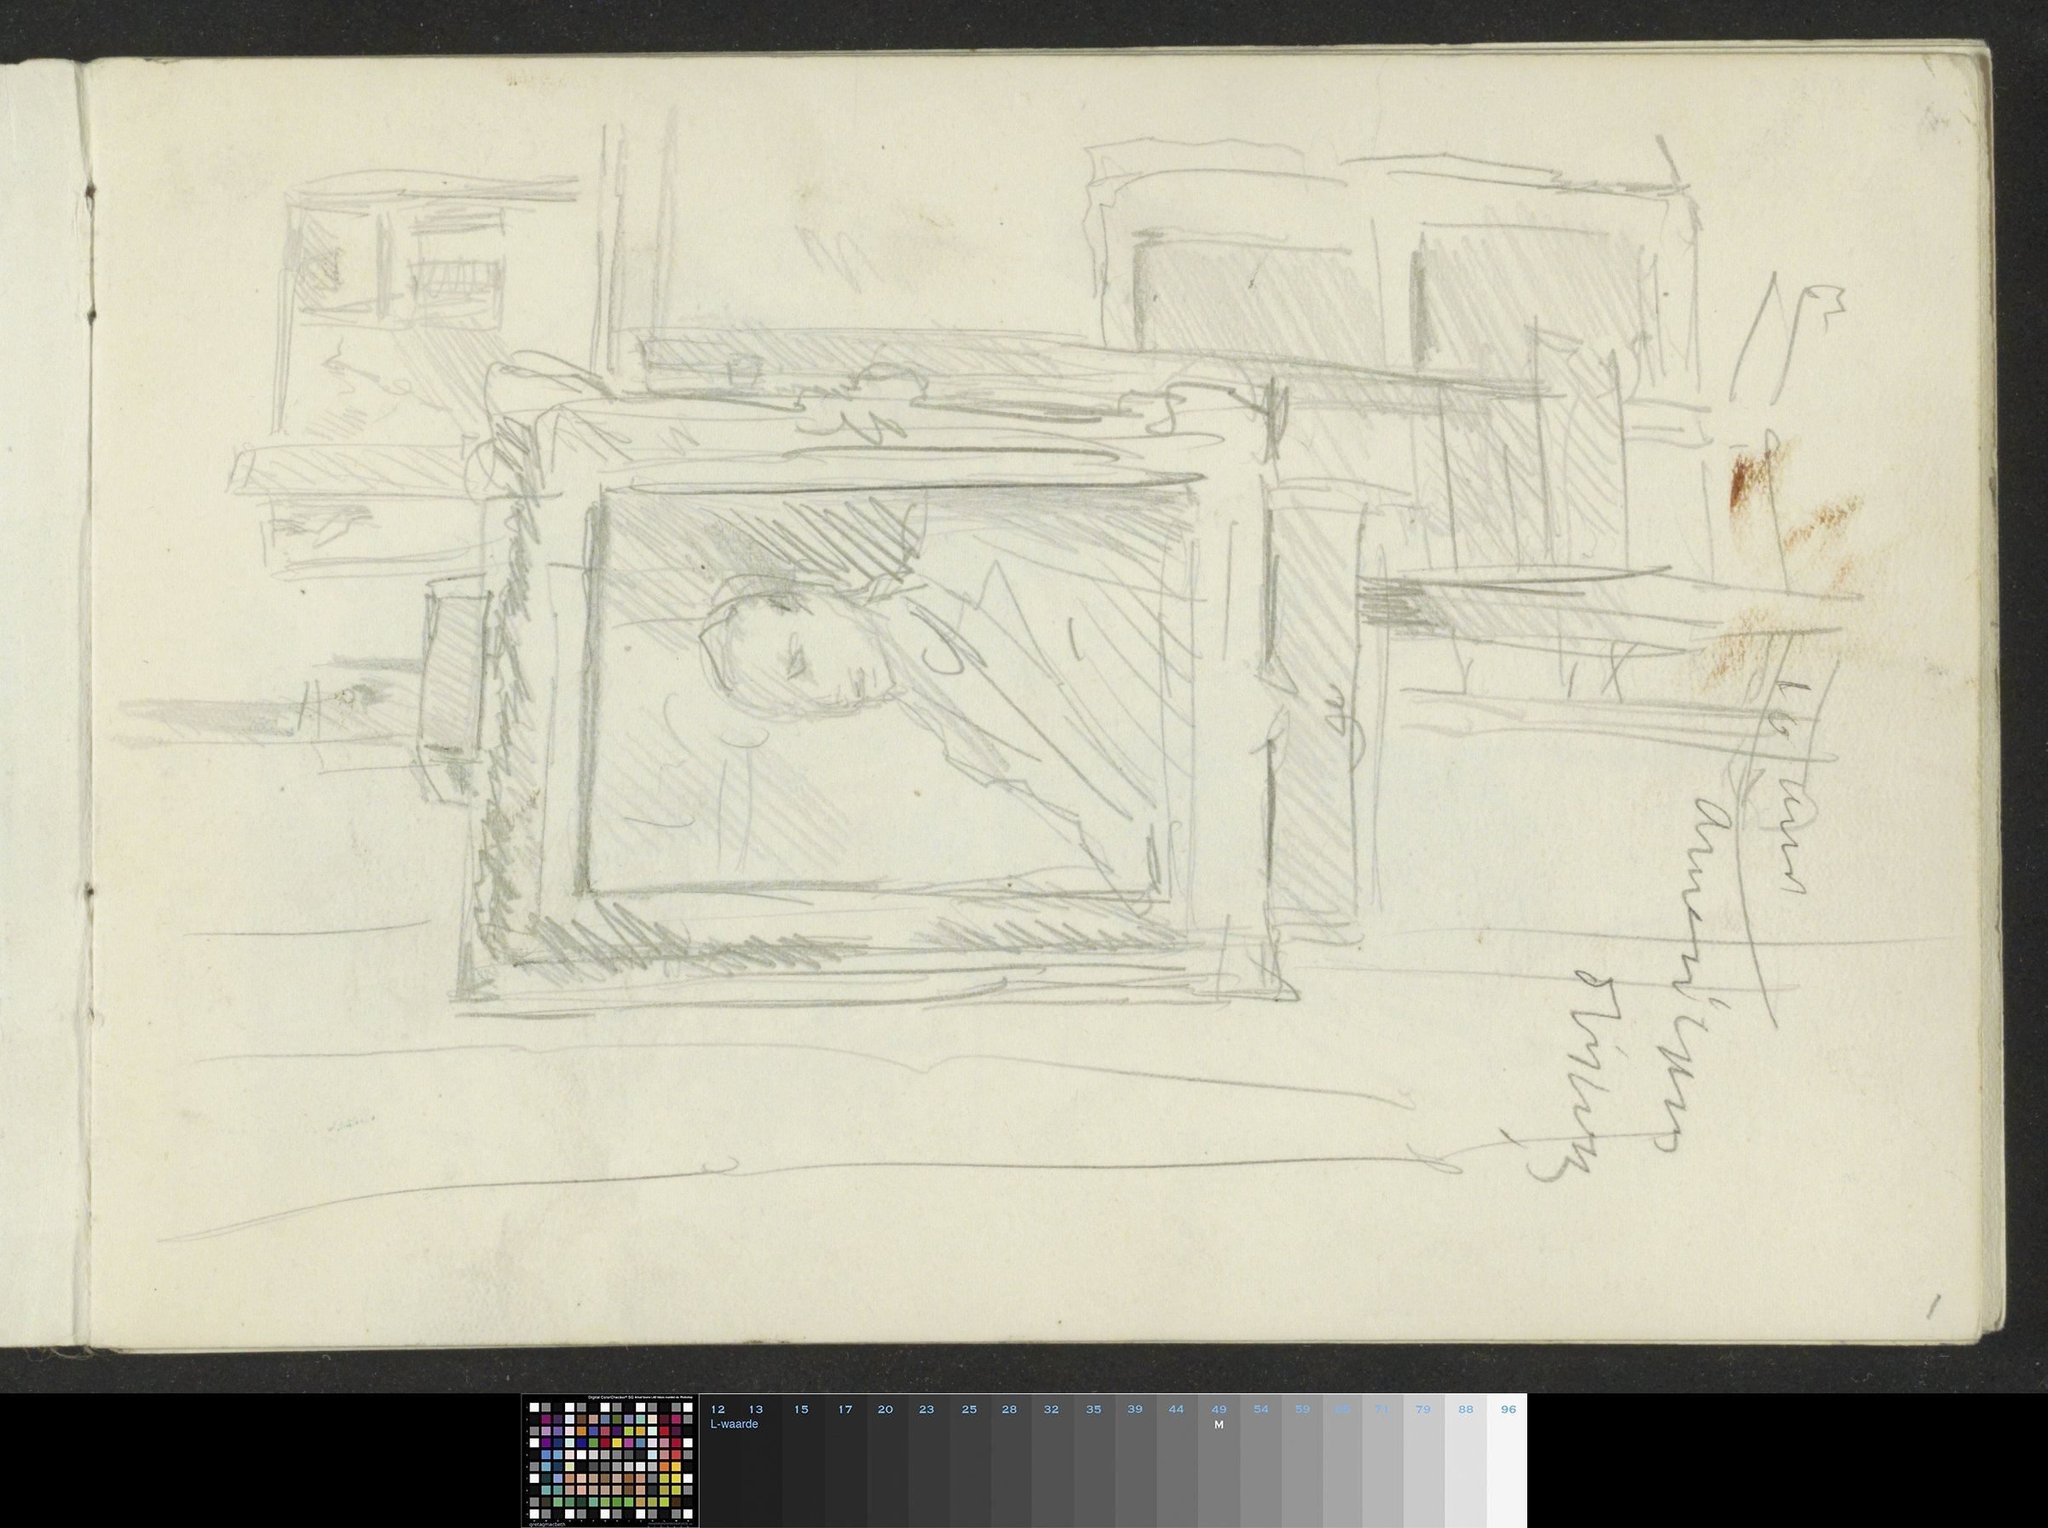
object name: sketchbook leaf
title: Schilderij op een ezel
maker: isaac israels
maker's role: draughtsman, painter, print maker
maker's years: 1865-1934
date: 1875-1934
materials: paper, pencil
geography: the hague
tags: easel, picture, painting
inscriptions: annotation: ‘10 uur / Arn[...] / slijpers[?]’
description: Portret van een onbekende man. Op de achtergrond nog enkele schilderijen en lijsten. Blad 1 recto uit schetsboek LXI met 20 bladen.